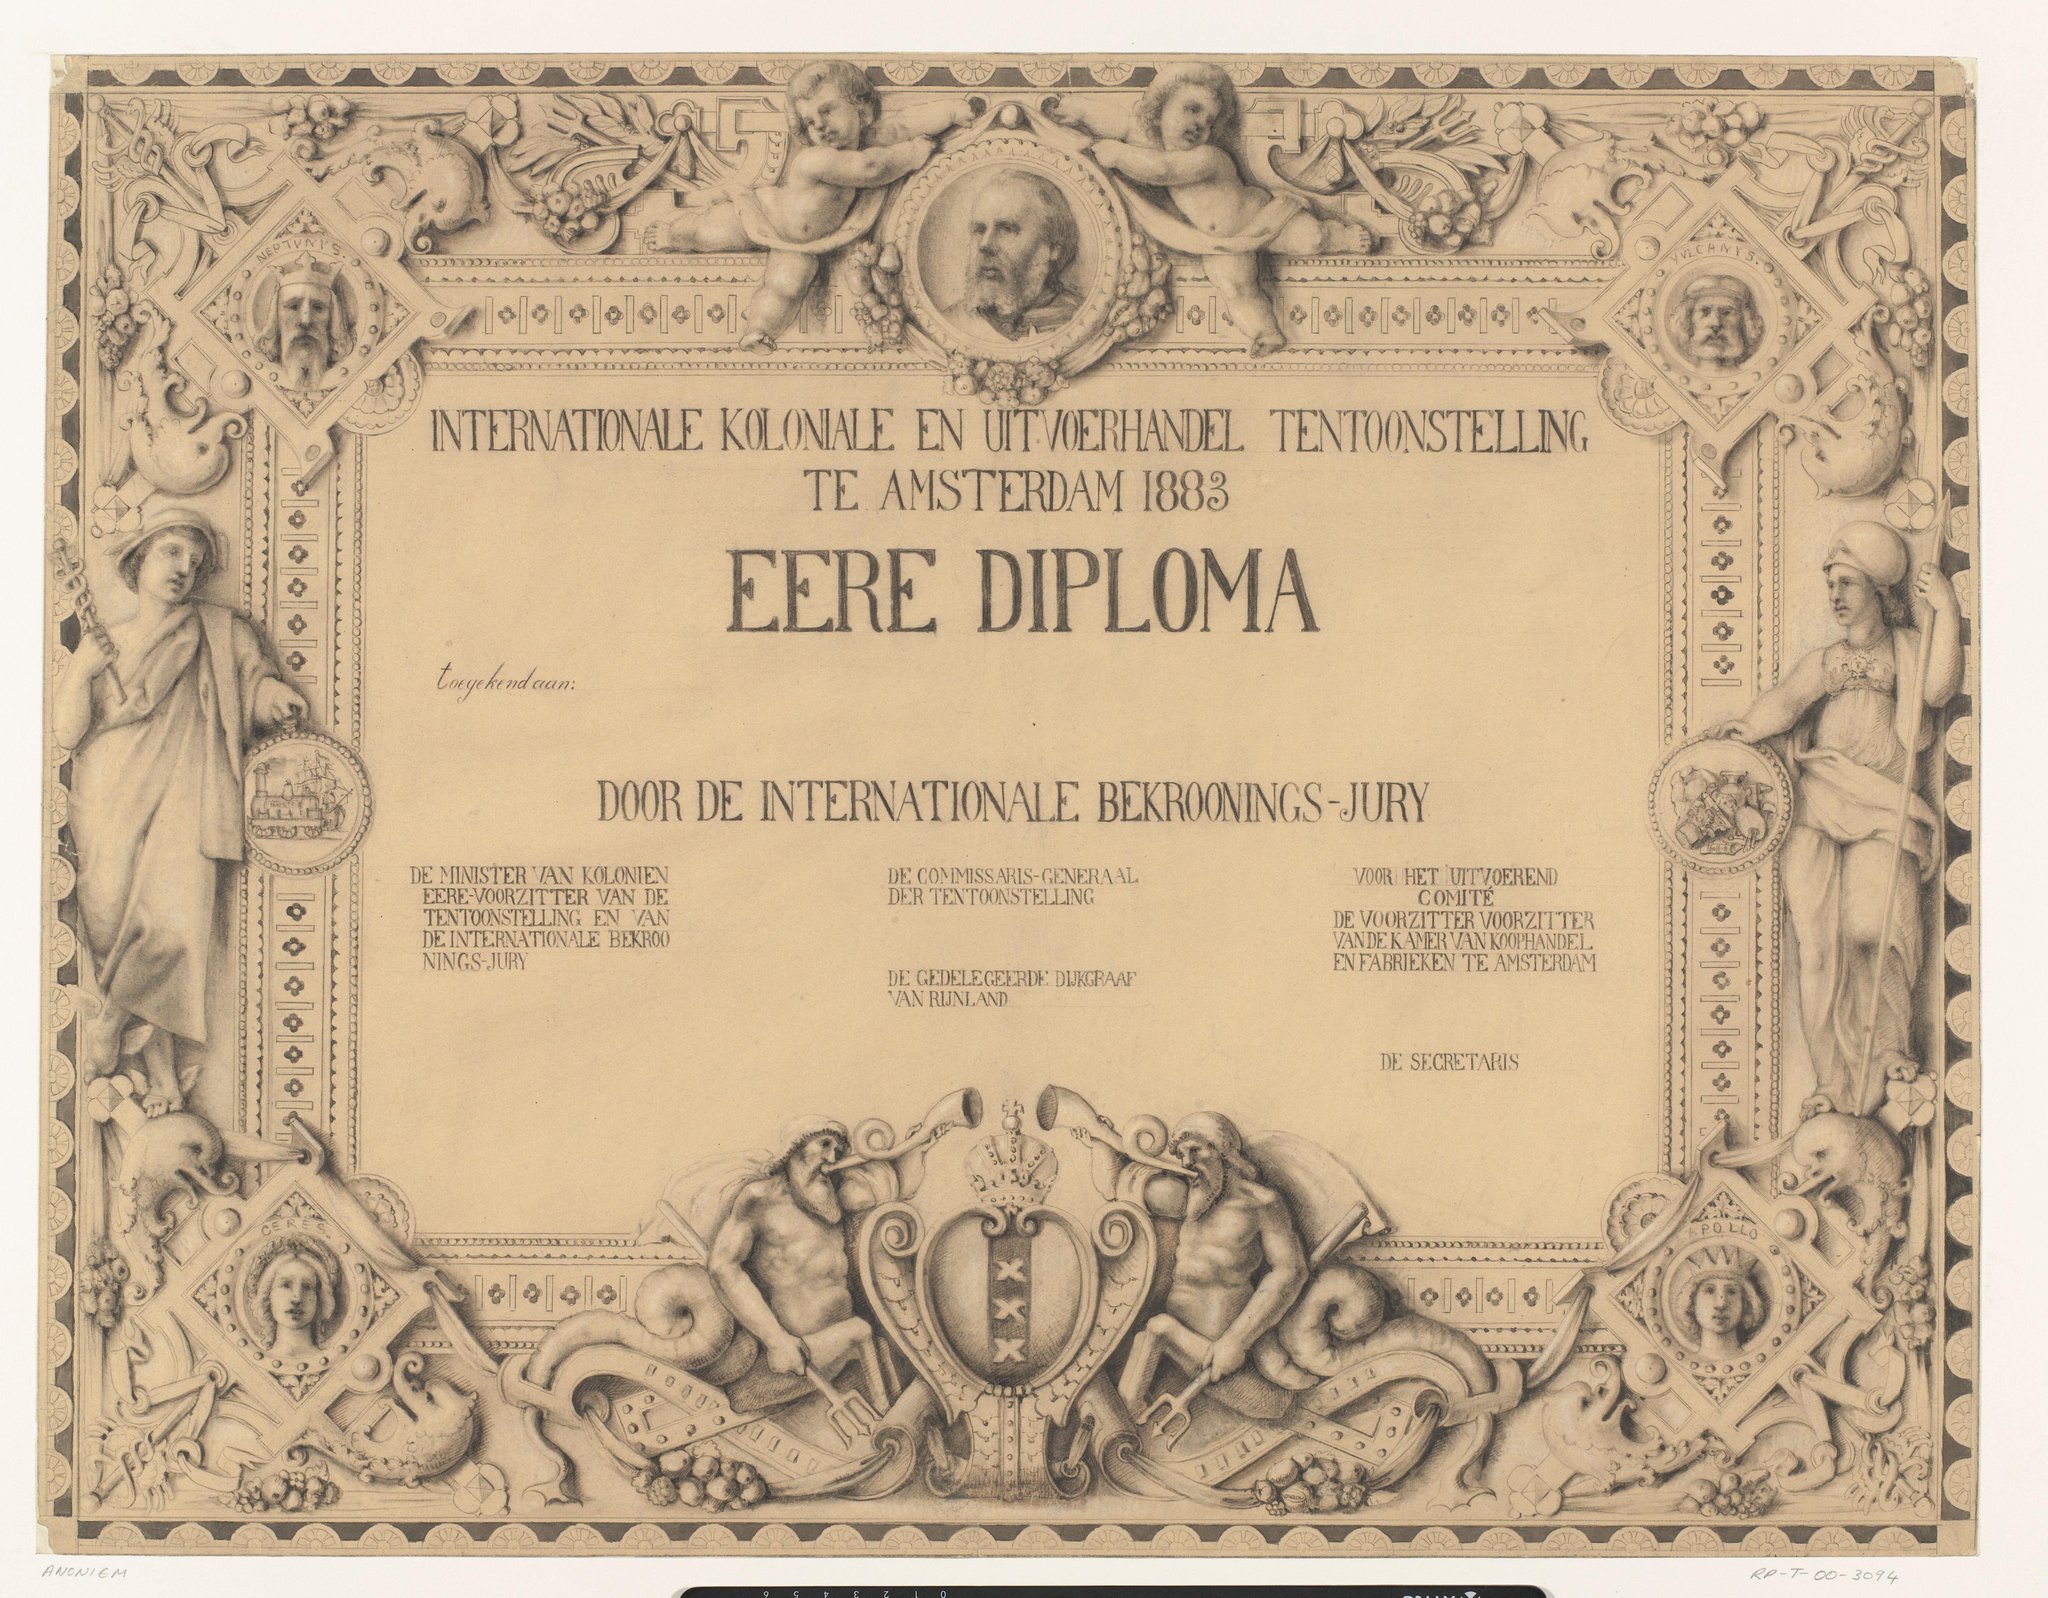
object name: drawing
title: Ontwerp voor een diploma, uitgereikt door de jury in het kader van de Internationale Koloniale en Uitvoerhandel Tentoonstelling te Amsterdam in 1883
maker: Anonymous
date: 1800-1900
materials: chalk, ink, paper, pencil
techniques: brush, pen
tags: trade exhibition, industries fair, single printed leaf: broadsheet, leaflet, historical events and situations, amsterdam